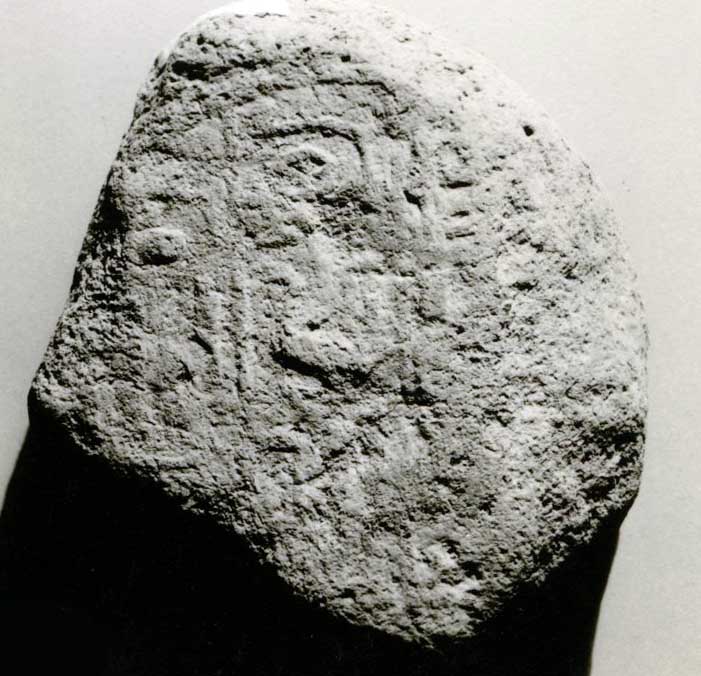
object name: cone, ptahmose, circular impression, high priest of amun, vizier, overseer, town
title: Funerary Cone of the Vizier Ptahmose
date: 1550-1295 BCE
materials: pottery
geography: egypt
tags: hieroglyphs